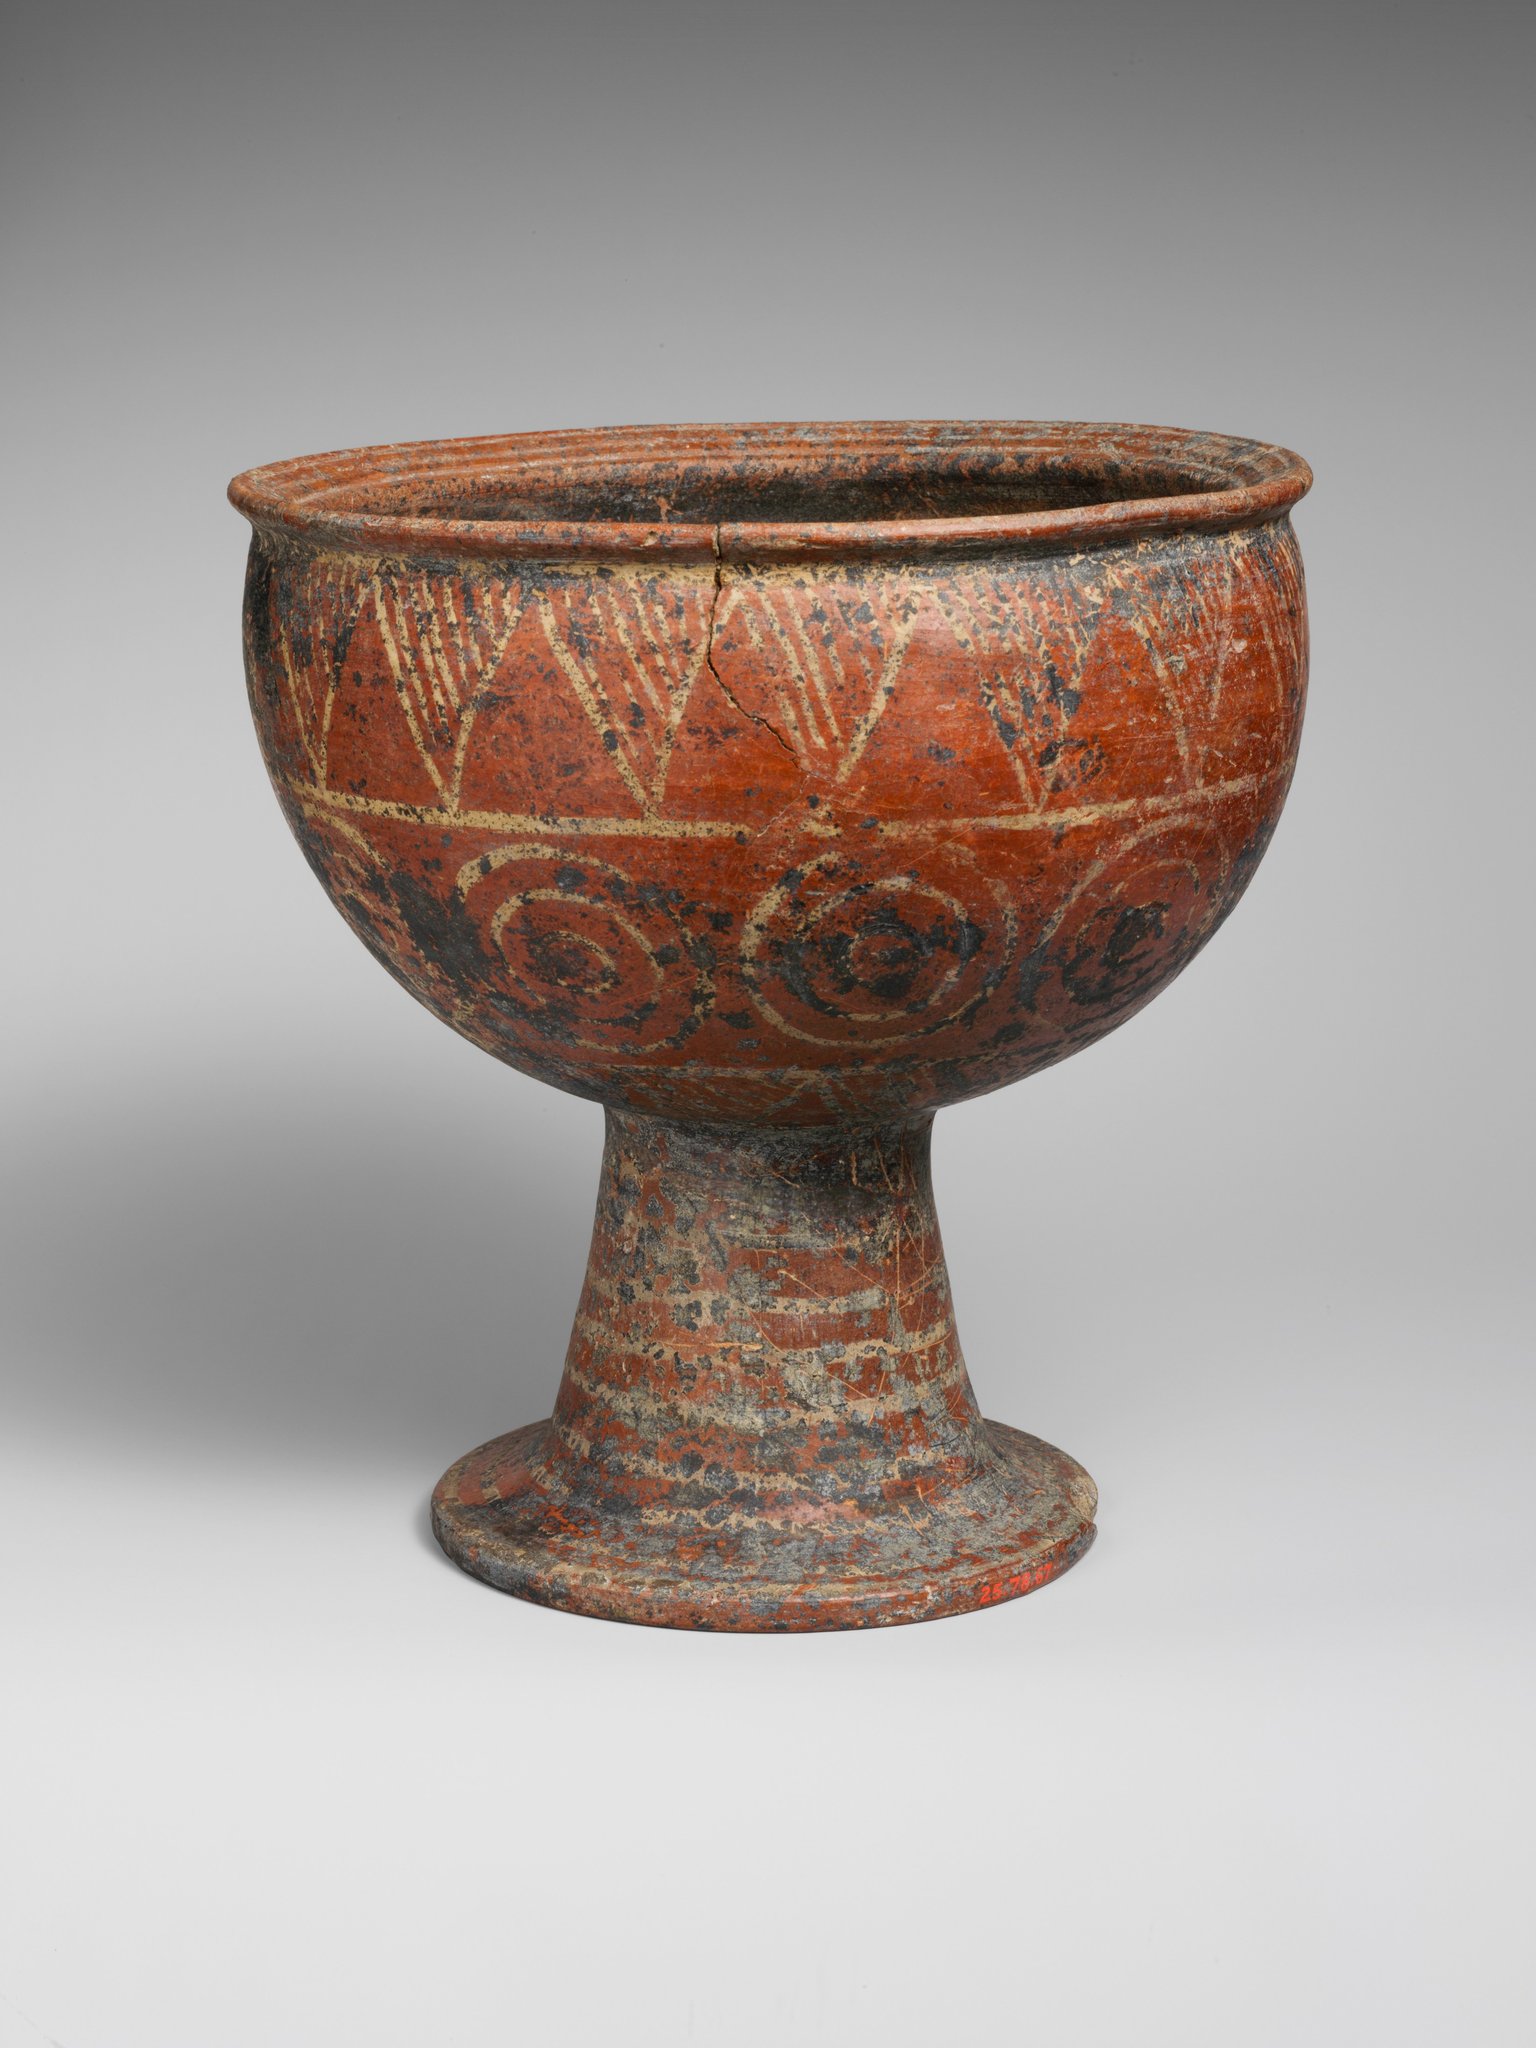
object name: bowl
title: Terracotta footed bowl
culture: etruscan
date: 650-625 BCE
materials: terracotta